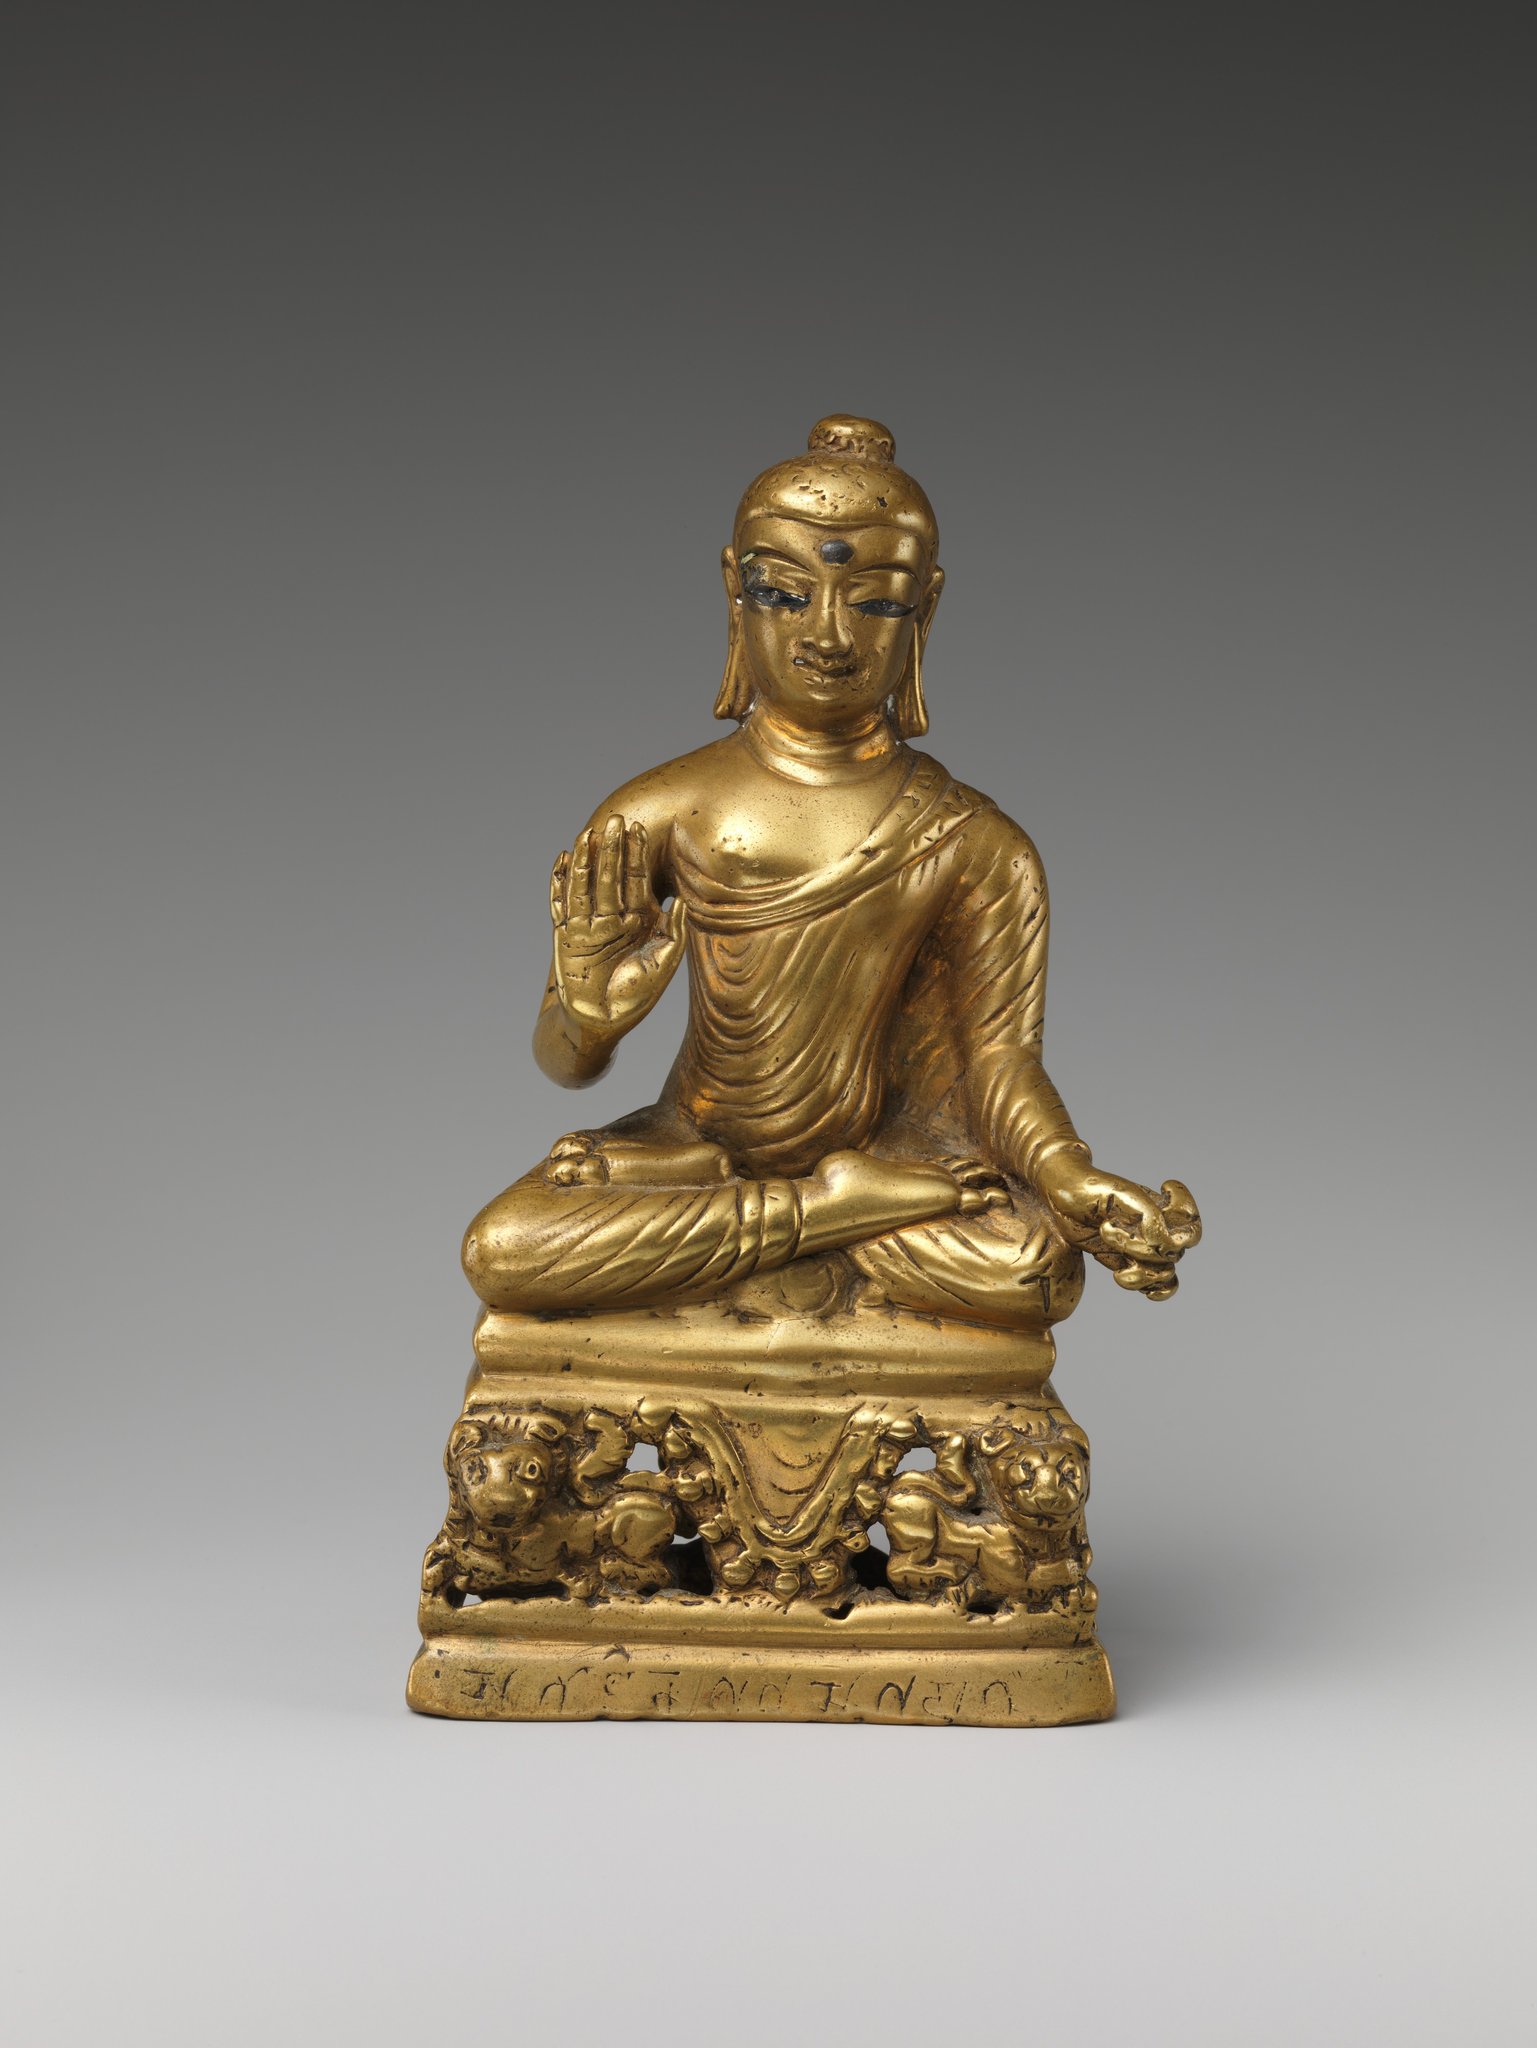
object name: figure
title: Seated Shakyamuni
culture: kashmiri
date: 801-900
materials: bronze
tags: kashmir,buddhism,shakyamuni